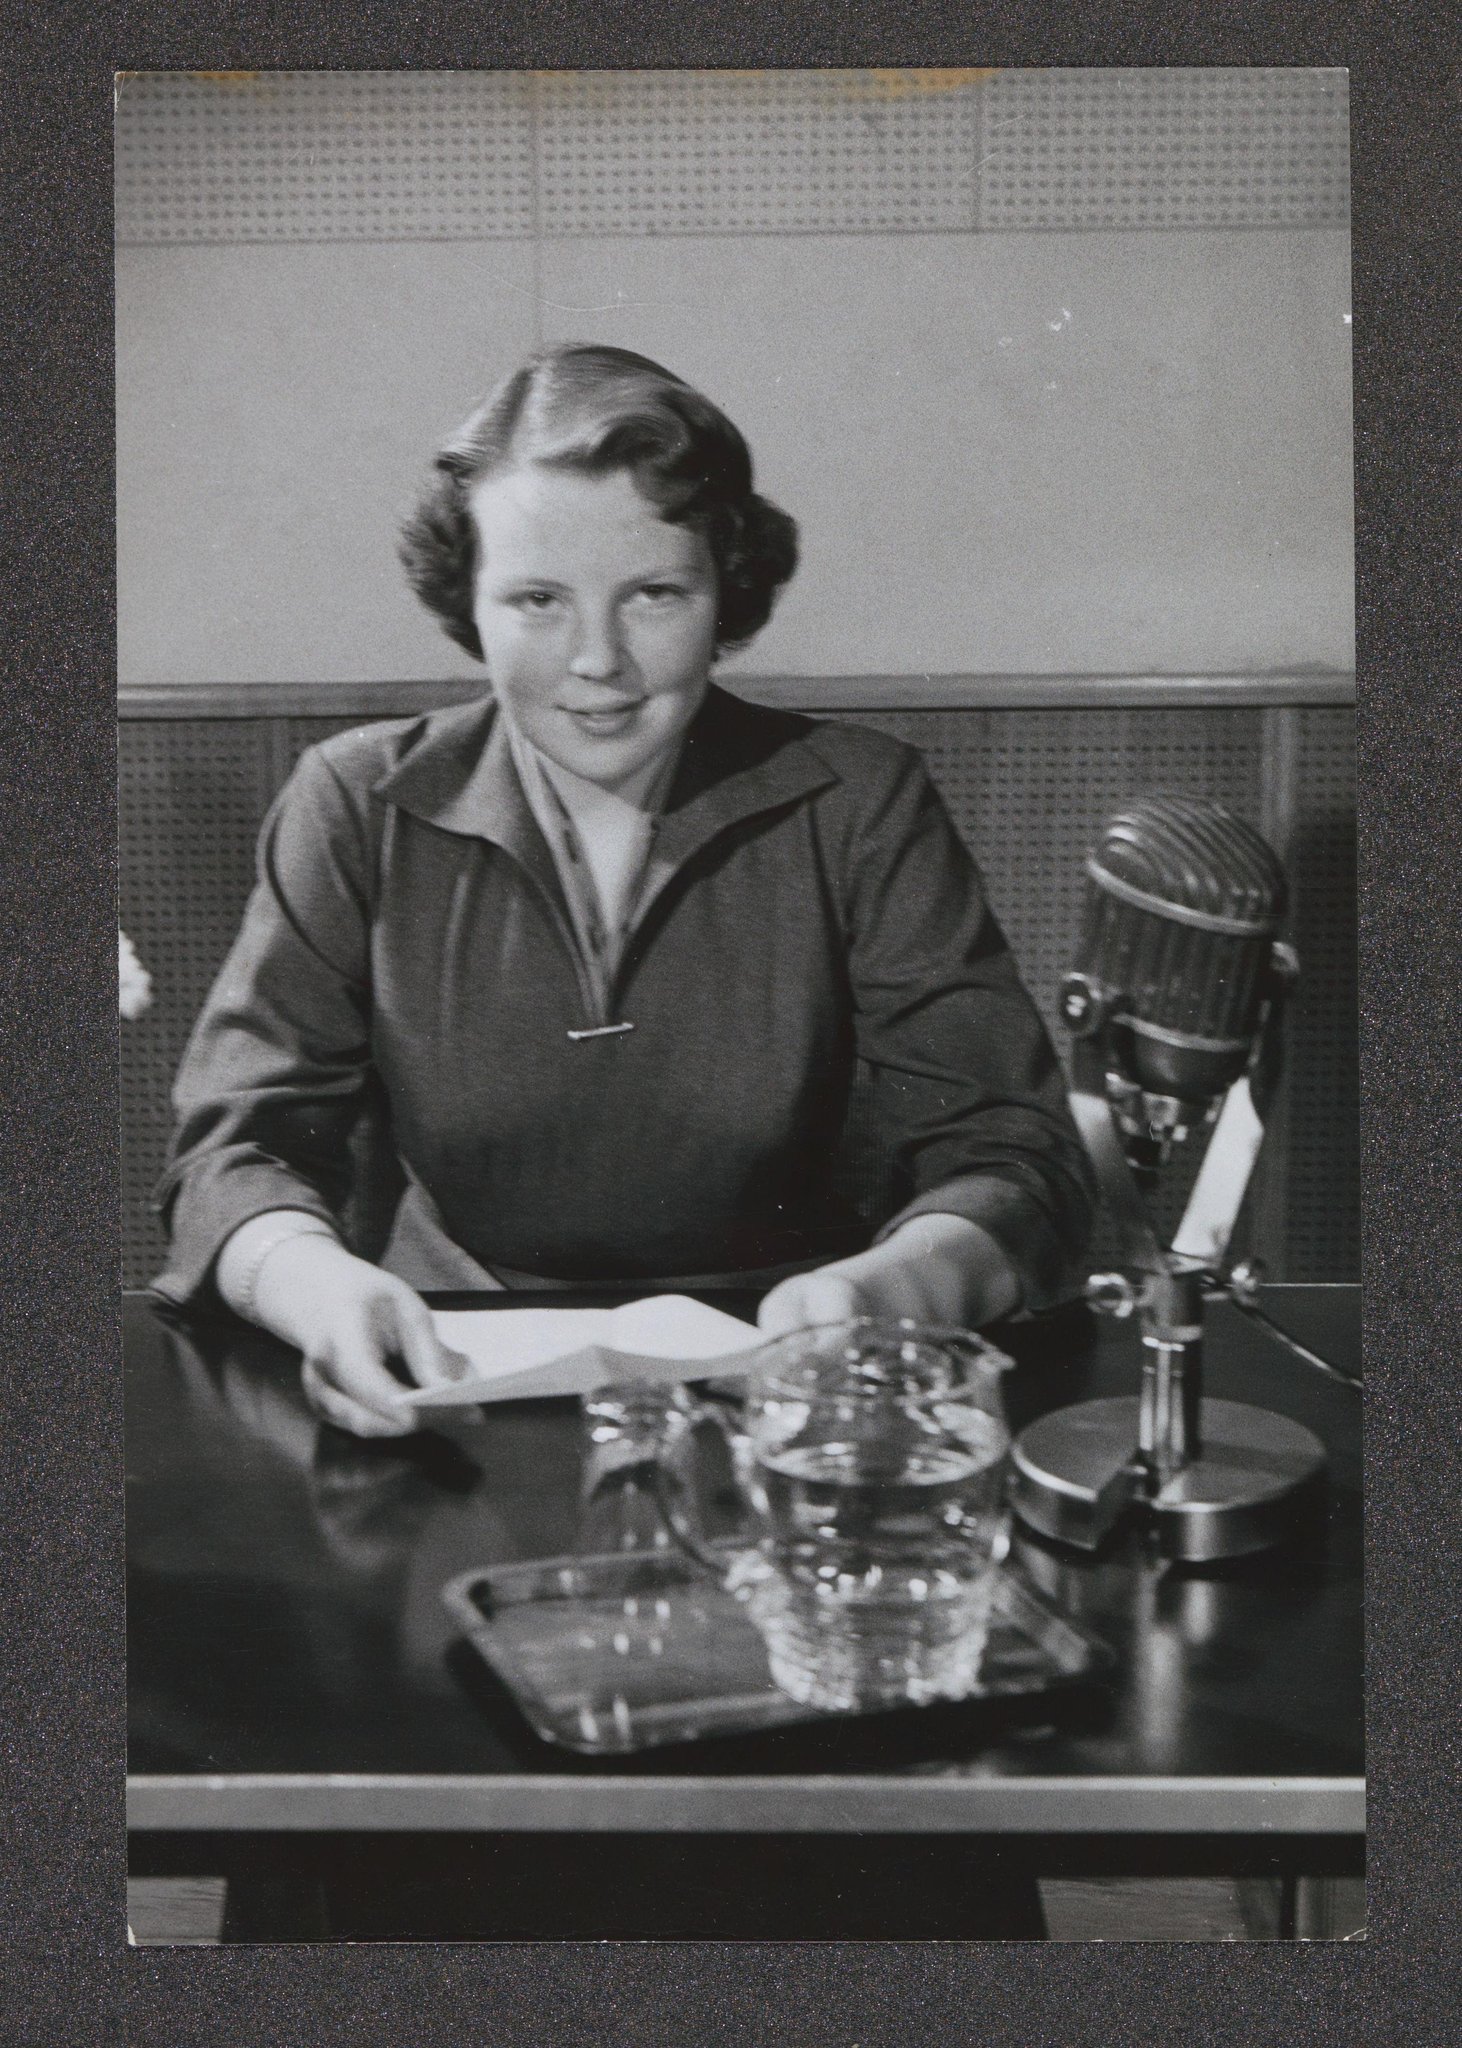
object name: photograph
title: Portret van Prinses Beatrix voorlezend achter microfoon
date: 1956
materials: paper, photographic support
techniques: gelatin silver print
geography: netherlands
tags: beatrix (koningin der nederlanden)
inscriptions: annotation: ‘H.K>H. Prinses Beatrix heeft via de radio een dankwoord gesproken tot het Nederlandse volk voor de blijken van medeleven ondervonden op haar 18-de verjaardag. FOTO-ANEFO 1-2-1956. Donderdag 2 februari vrij voor publicatie’